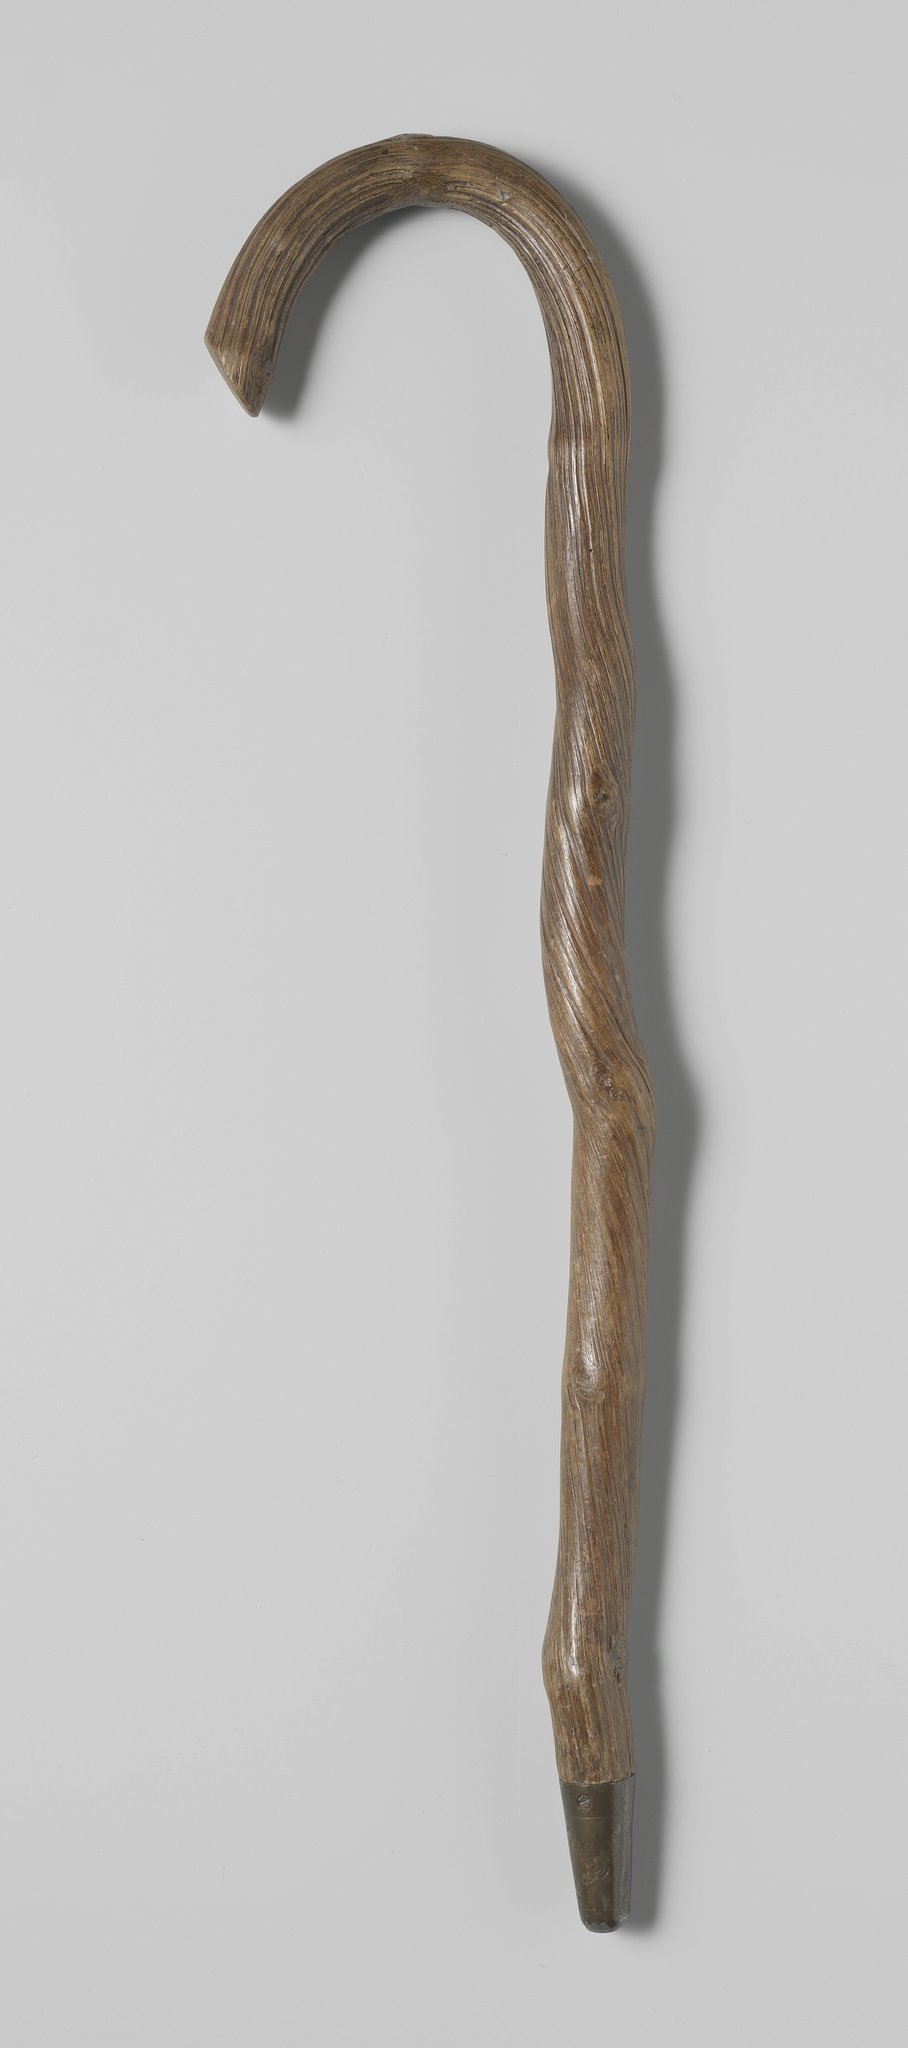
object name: walking stick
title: Stok van een dikke tak in draaigroei met een koperen stootdop, waarin 'SAMADI, WASPADA GAROET' is gegraveerd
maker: Anonymous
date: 1890-1910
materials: copper, wood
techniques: cutting, engraving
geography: indonesia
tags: garut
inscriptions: inscription: ‘SAMADI WASPADA GAROET’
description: Stok van een dikke tak in draaigroei met een koperen stootdop, waarin 'SAMADI, WASPADA GAROET' is gegraveerd. Bergstok.